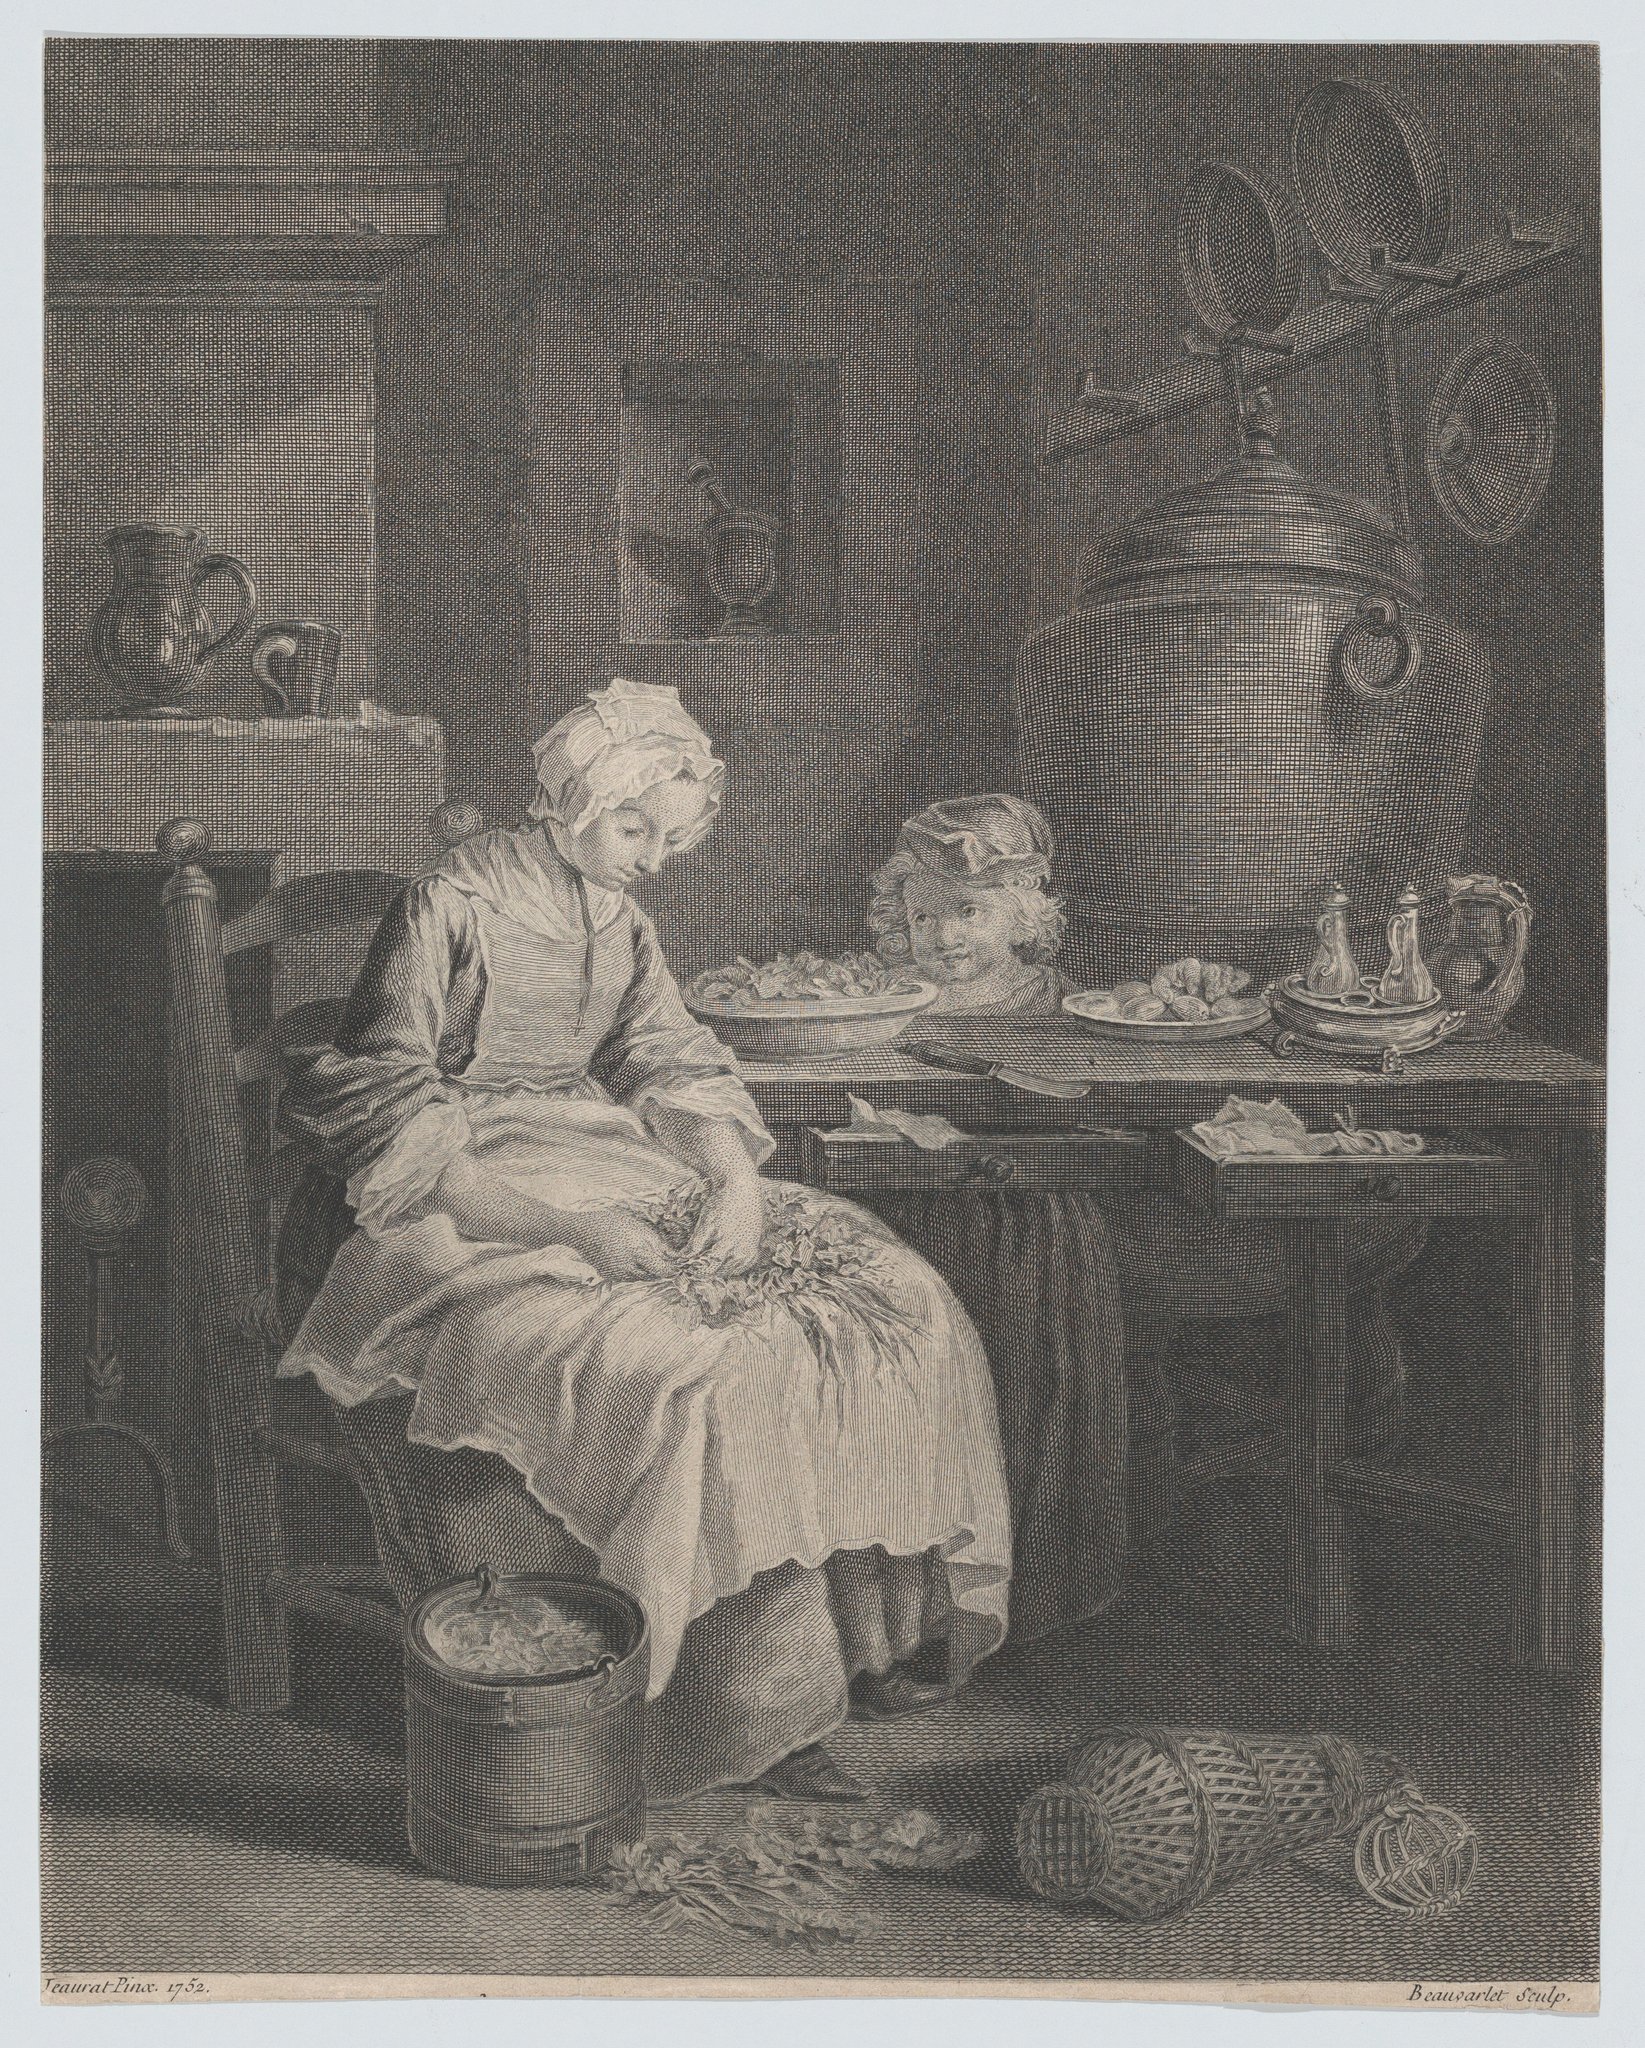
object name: print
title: The Salad Washer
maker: jacques firmin beauvarlet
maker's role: etcher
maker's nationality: french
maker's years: 1731-1797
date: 1752-1760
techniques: etching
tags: food,kitchens,children,women,cooking